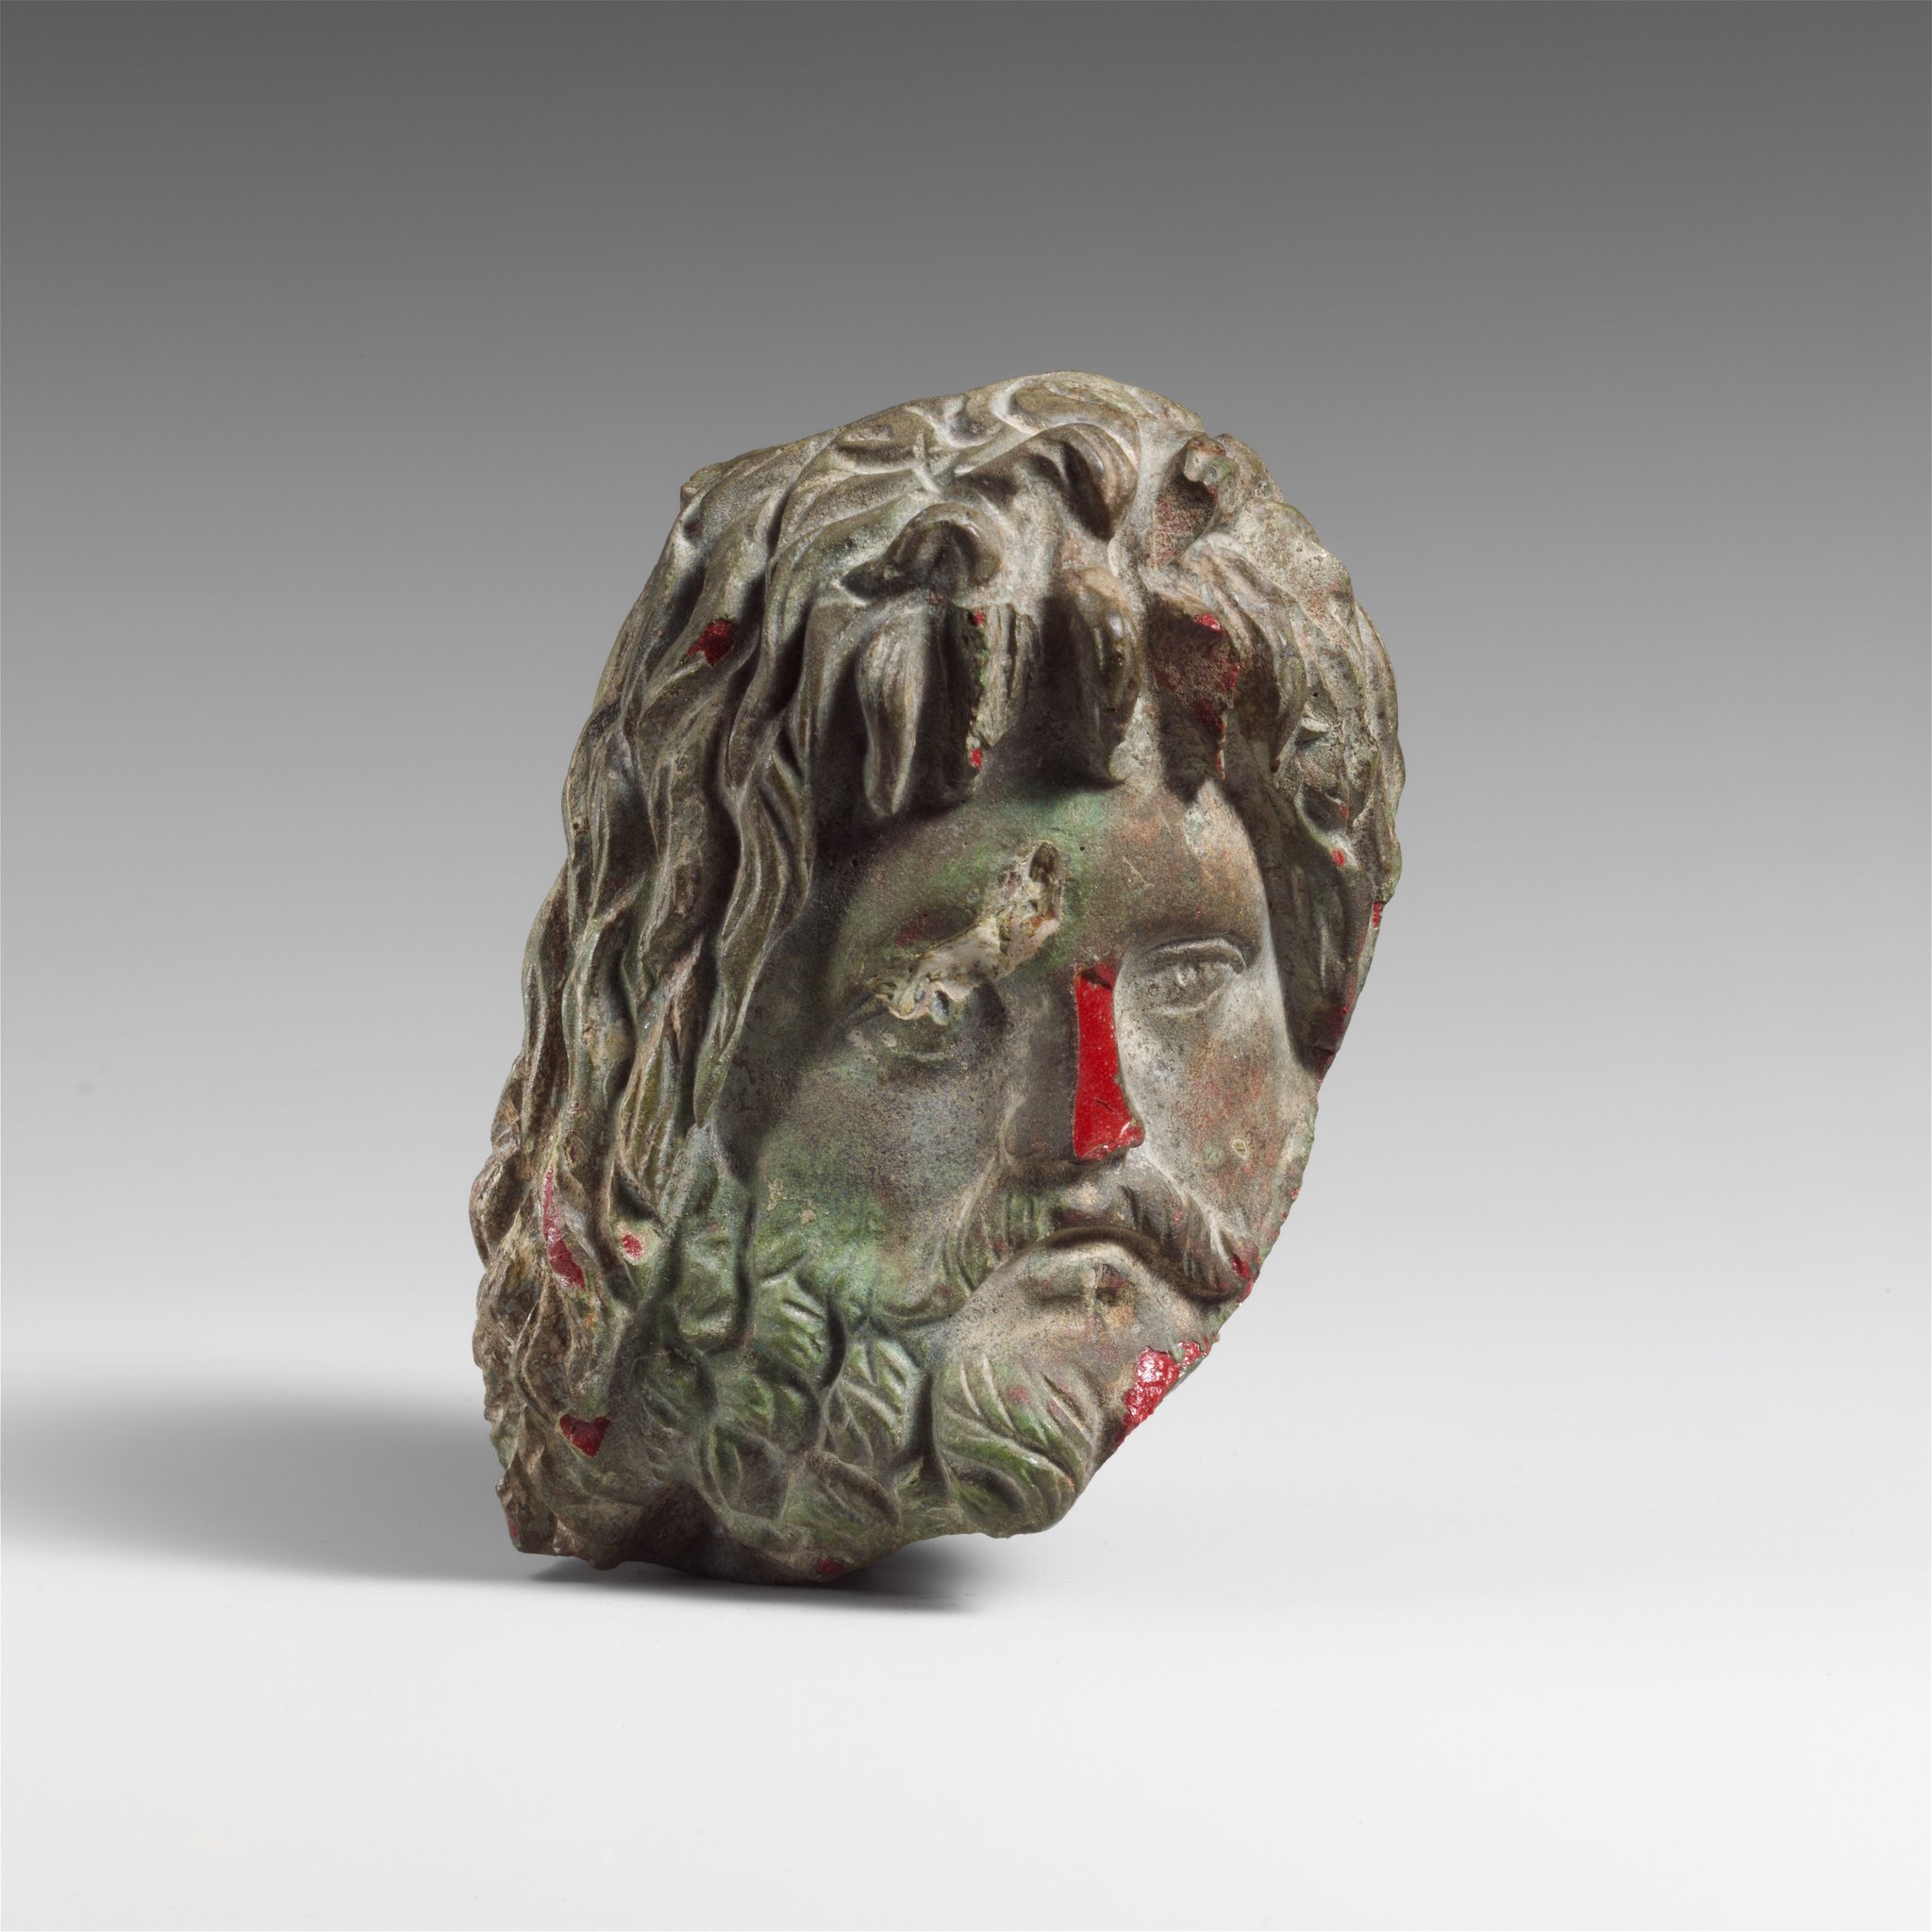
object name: head of zeus sarapis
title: Glass head of Zeus Sarapis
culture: roman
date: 1-200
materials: glass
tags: heads,zeus